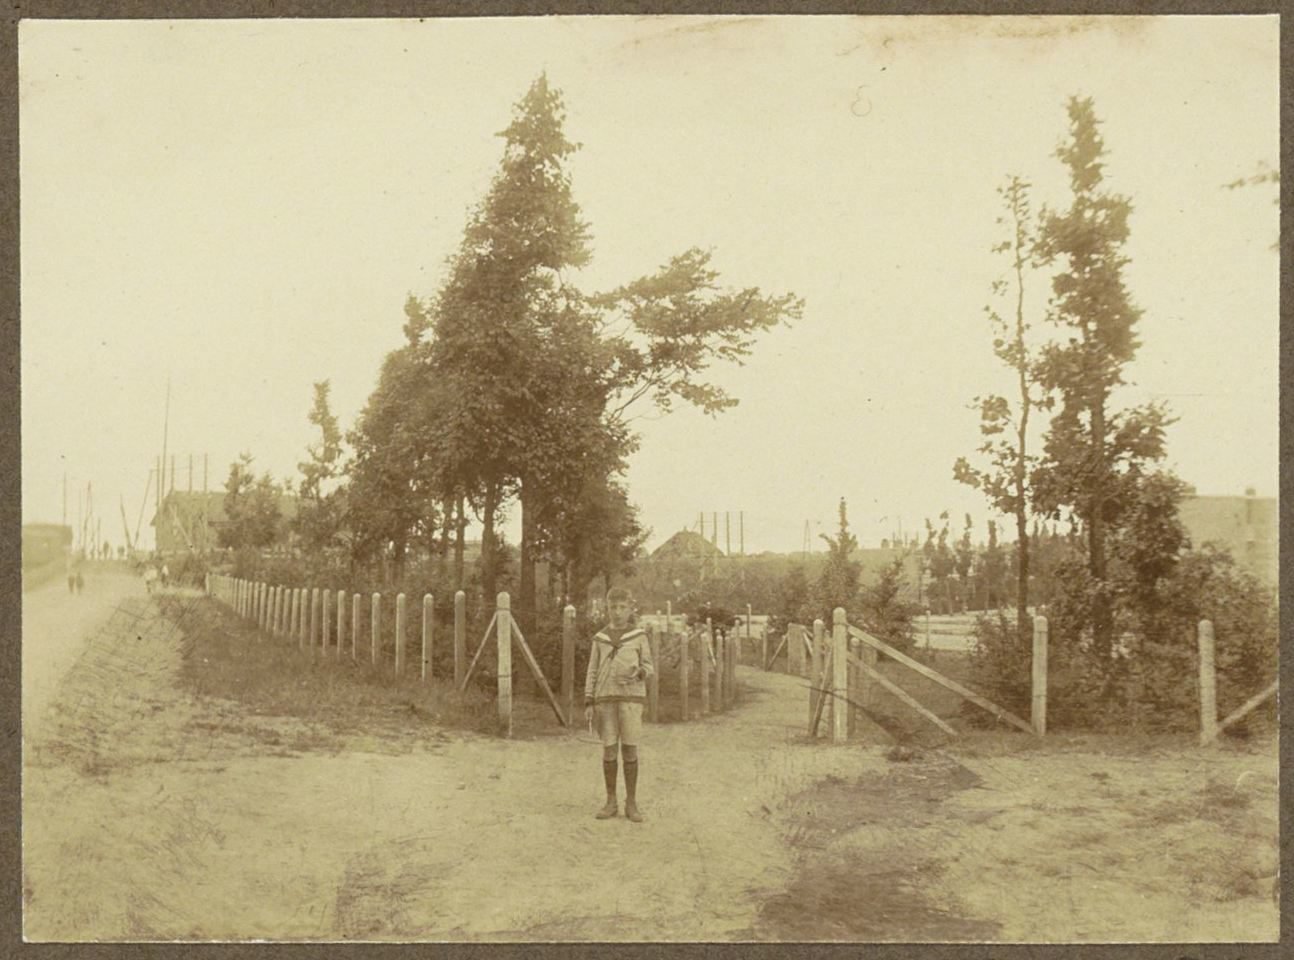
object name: photograph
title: Jongen op een pad bij de Ringdijk in Amsterdam-Oost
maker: Anonymous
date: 1910-1930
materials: paper, photographic support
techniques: daylight paper print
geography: amsterdam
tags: road, path, amsterdam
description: Onderdeel van Album met foto's van Amsterdam en omgeving.